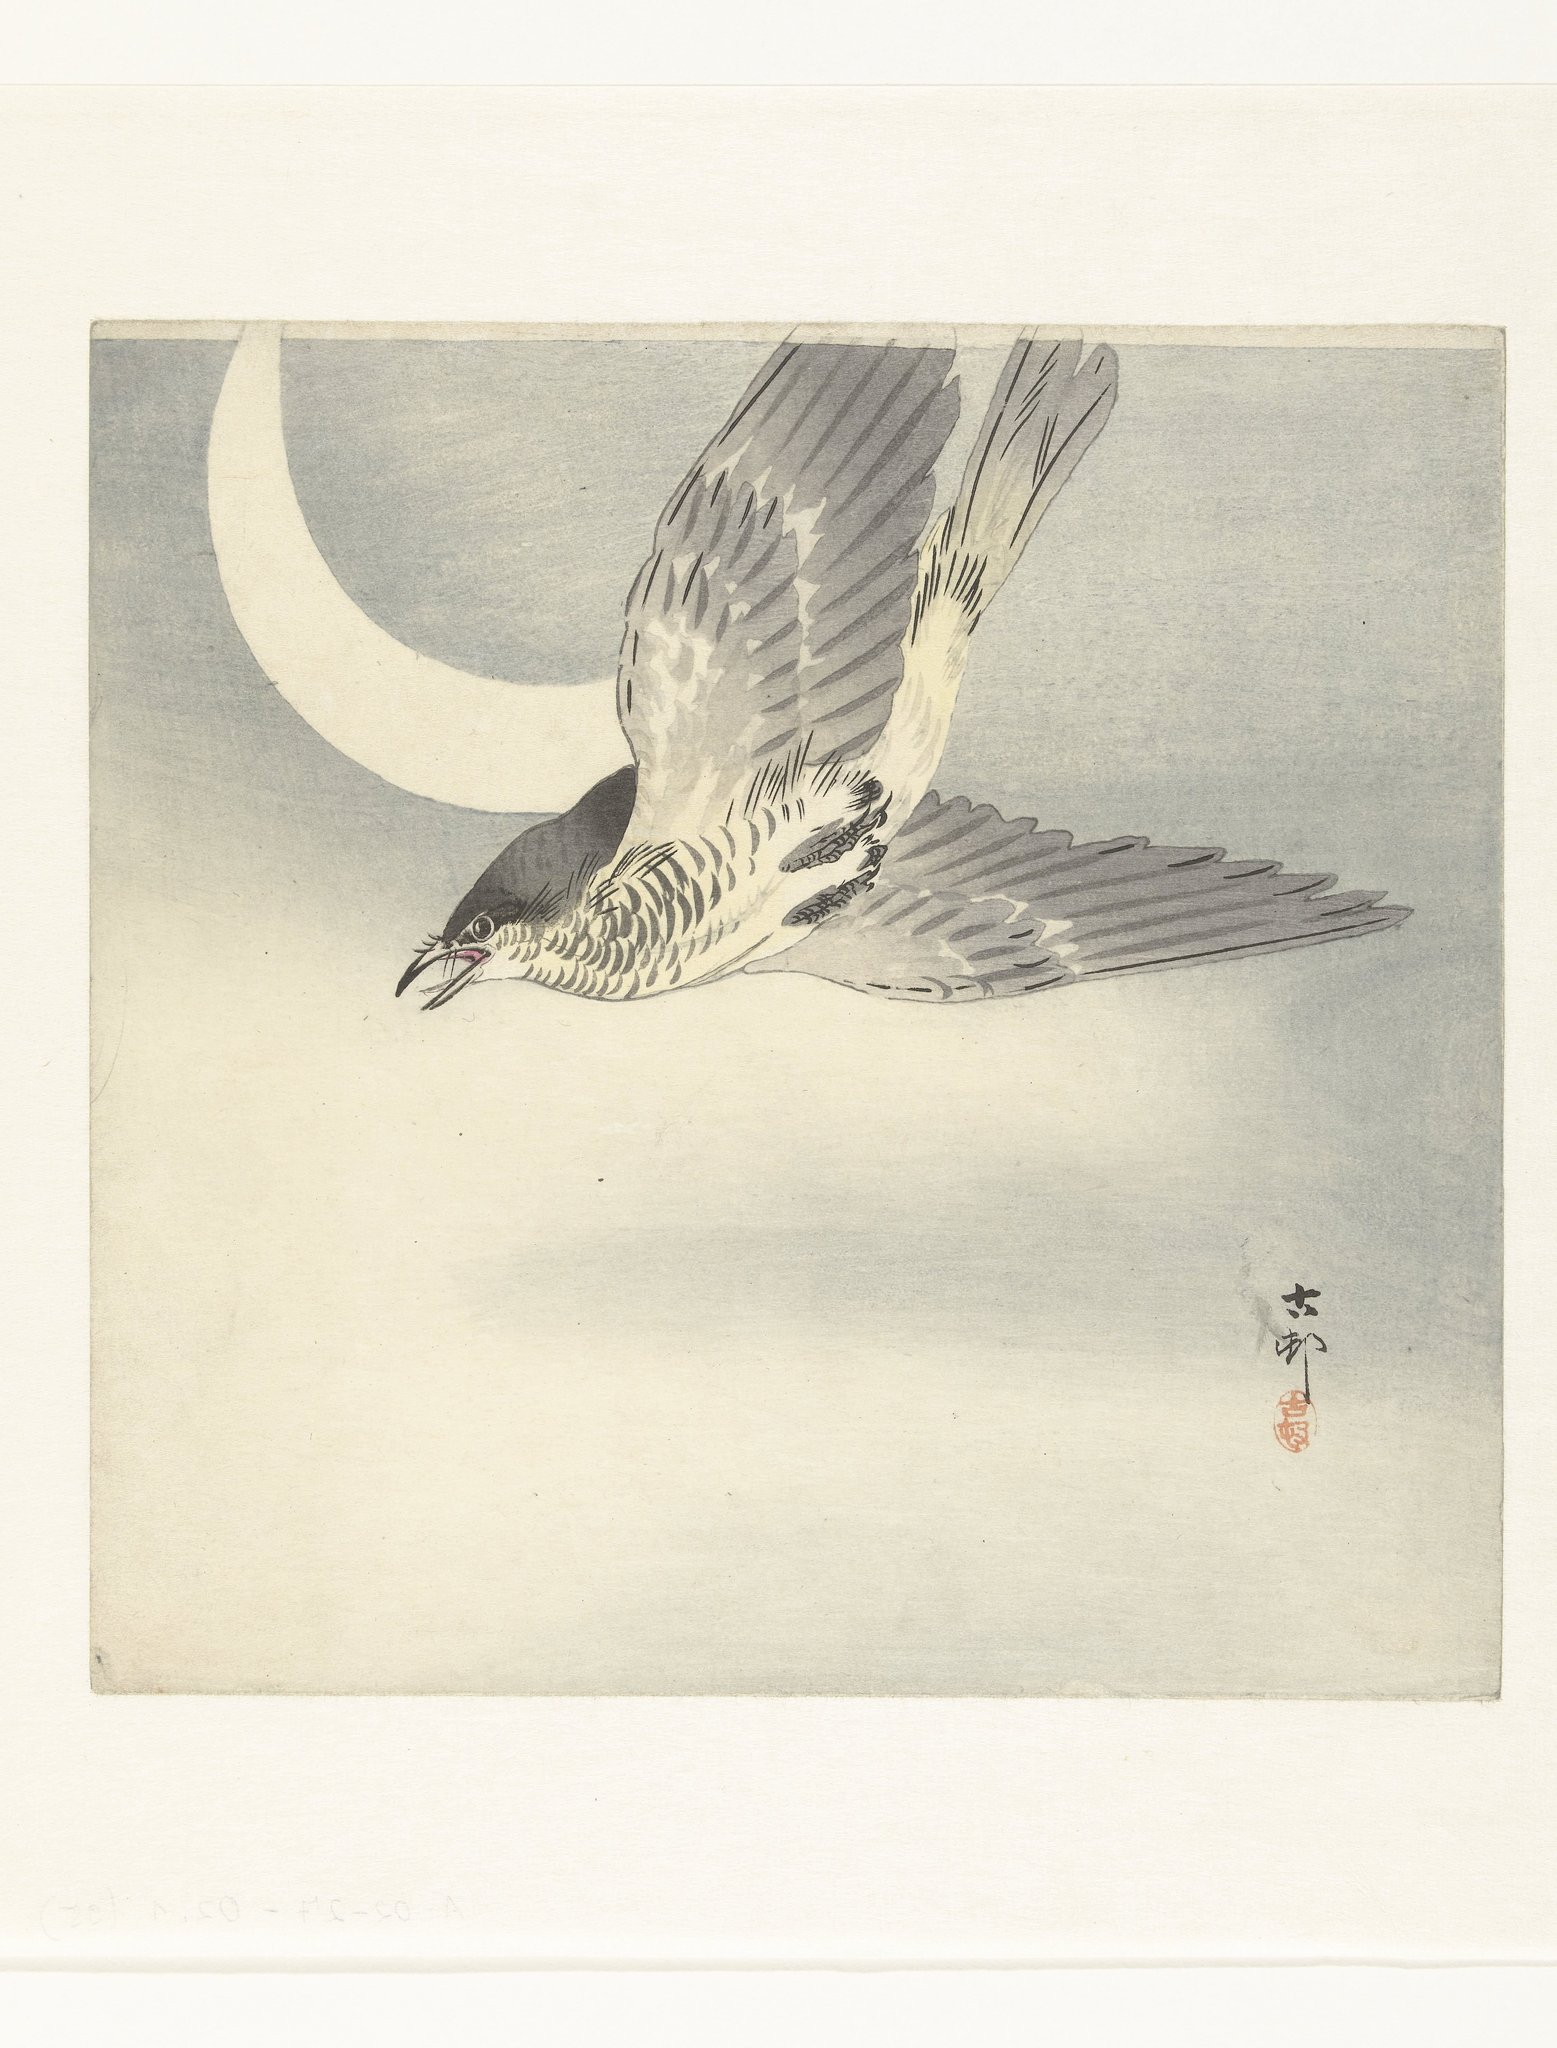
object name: print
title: Koekoek bij wassende maan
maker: ohara koson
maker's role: print maker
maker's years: 1877-1945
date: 1900-1930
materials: paper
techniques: woodcut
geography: tokyo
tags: other birds: cuckoo, moon as celestial body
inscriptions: collector's mark: Lugt 2228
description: Koekoek, in volle vlucht naar links, bij maansikkel